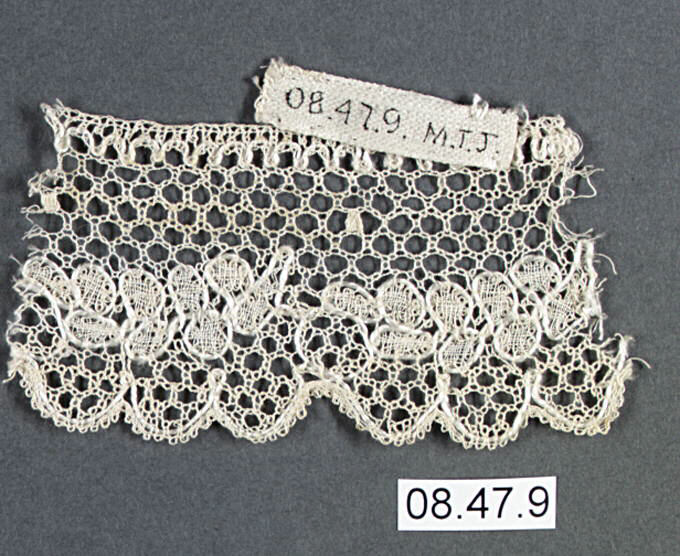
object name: fragment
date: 1801-1900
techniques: lace